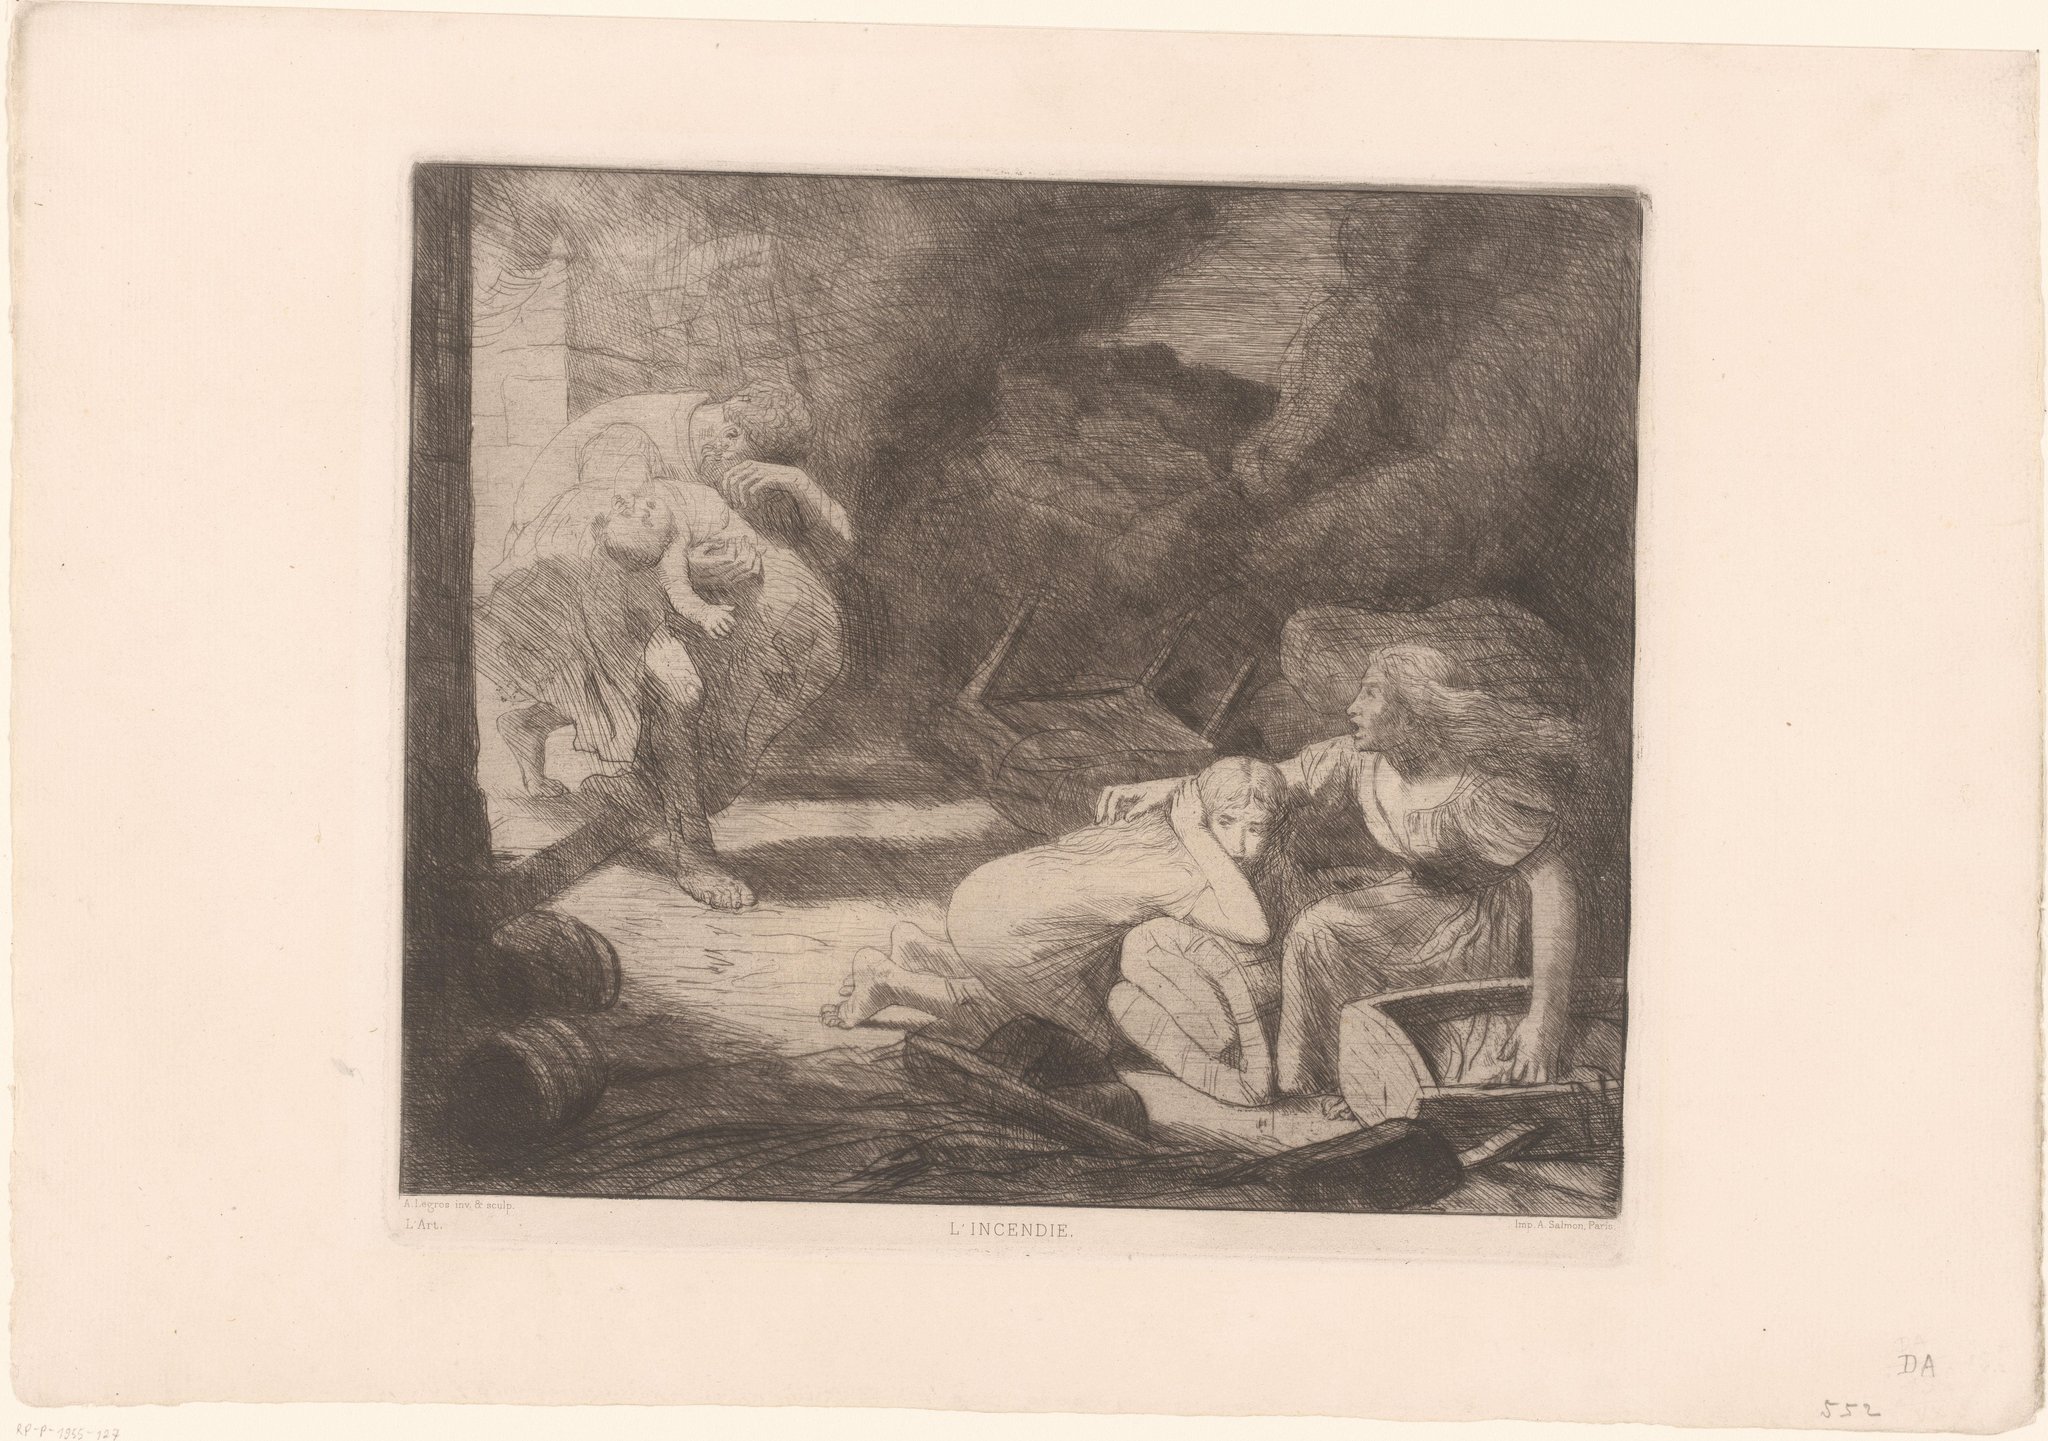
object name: print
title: L'Incendie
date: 1875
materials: paper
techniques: drypoint, engraving, intaglio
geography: paris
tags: rescue from fire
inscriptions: collector's mark: Lugt 2228